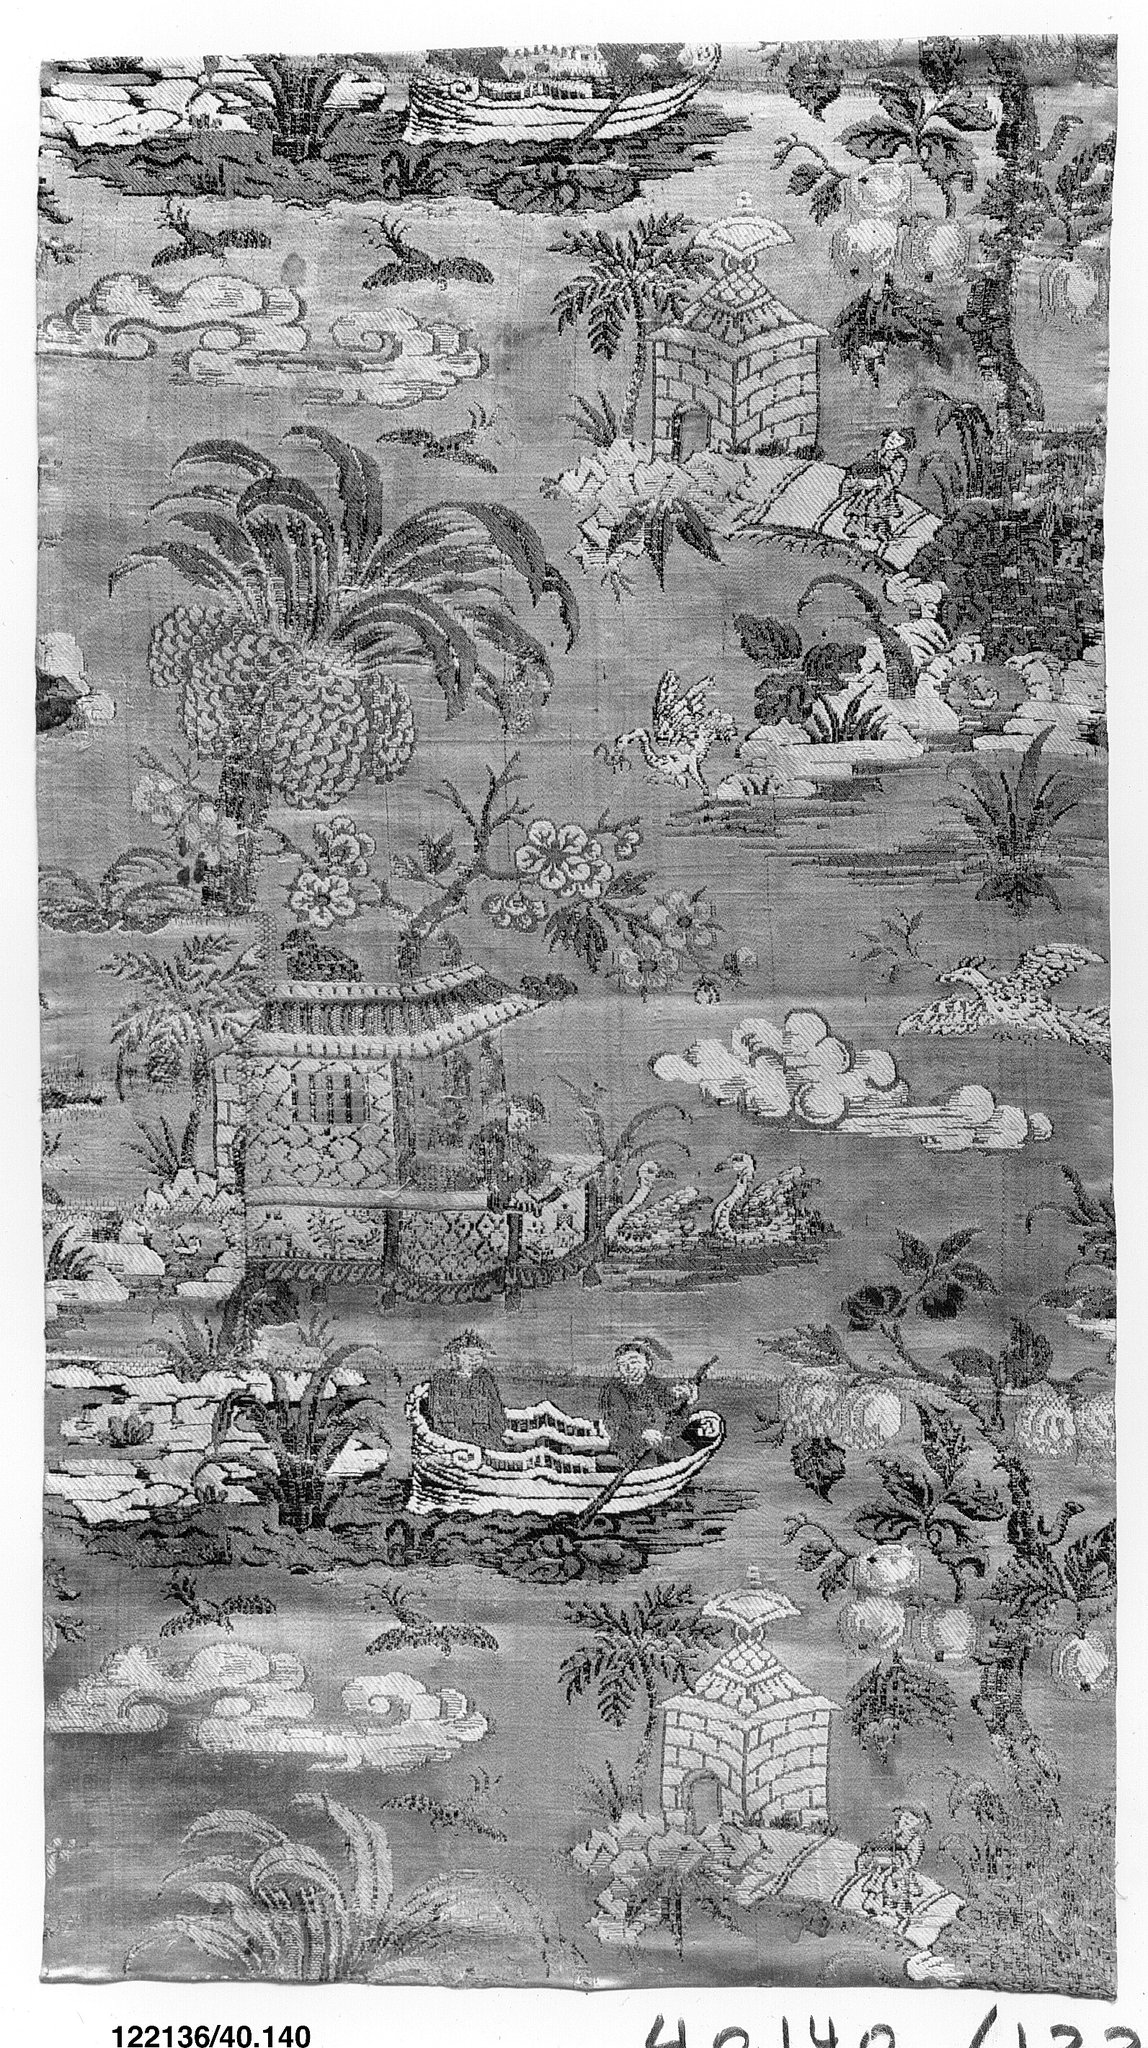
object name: piece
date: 1740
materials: silk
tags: human figures,chinoiserie,swans,trees,boats